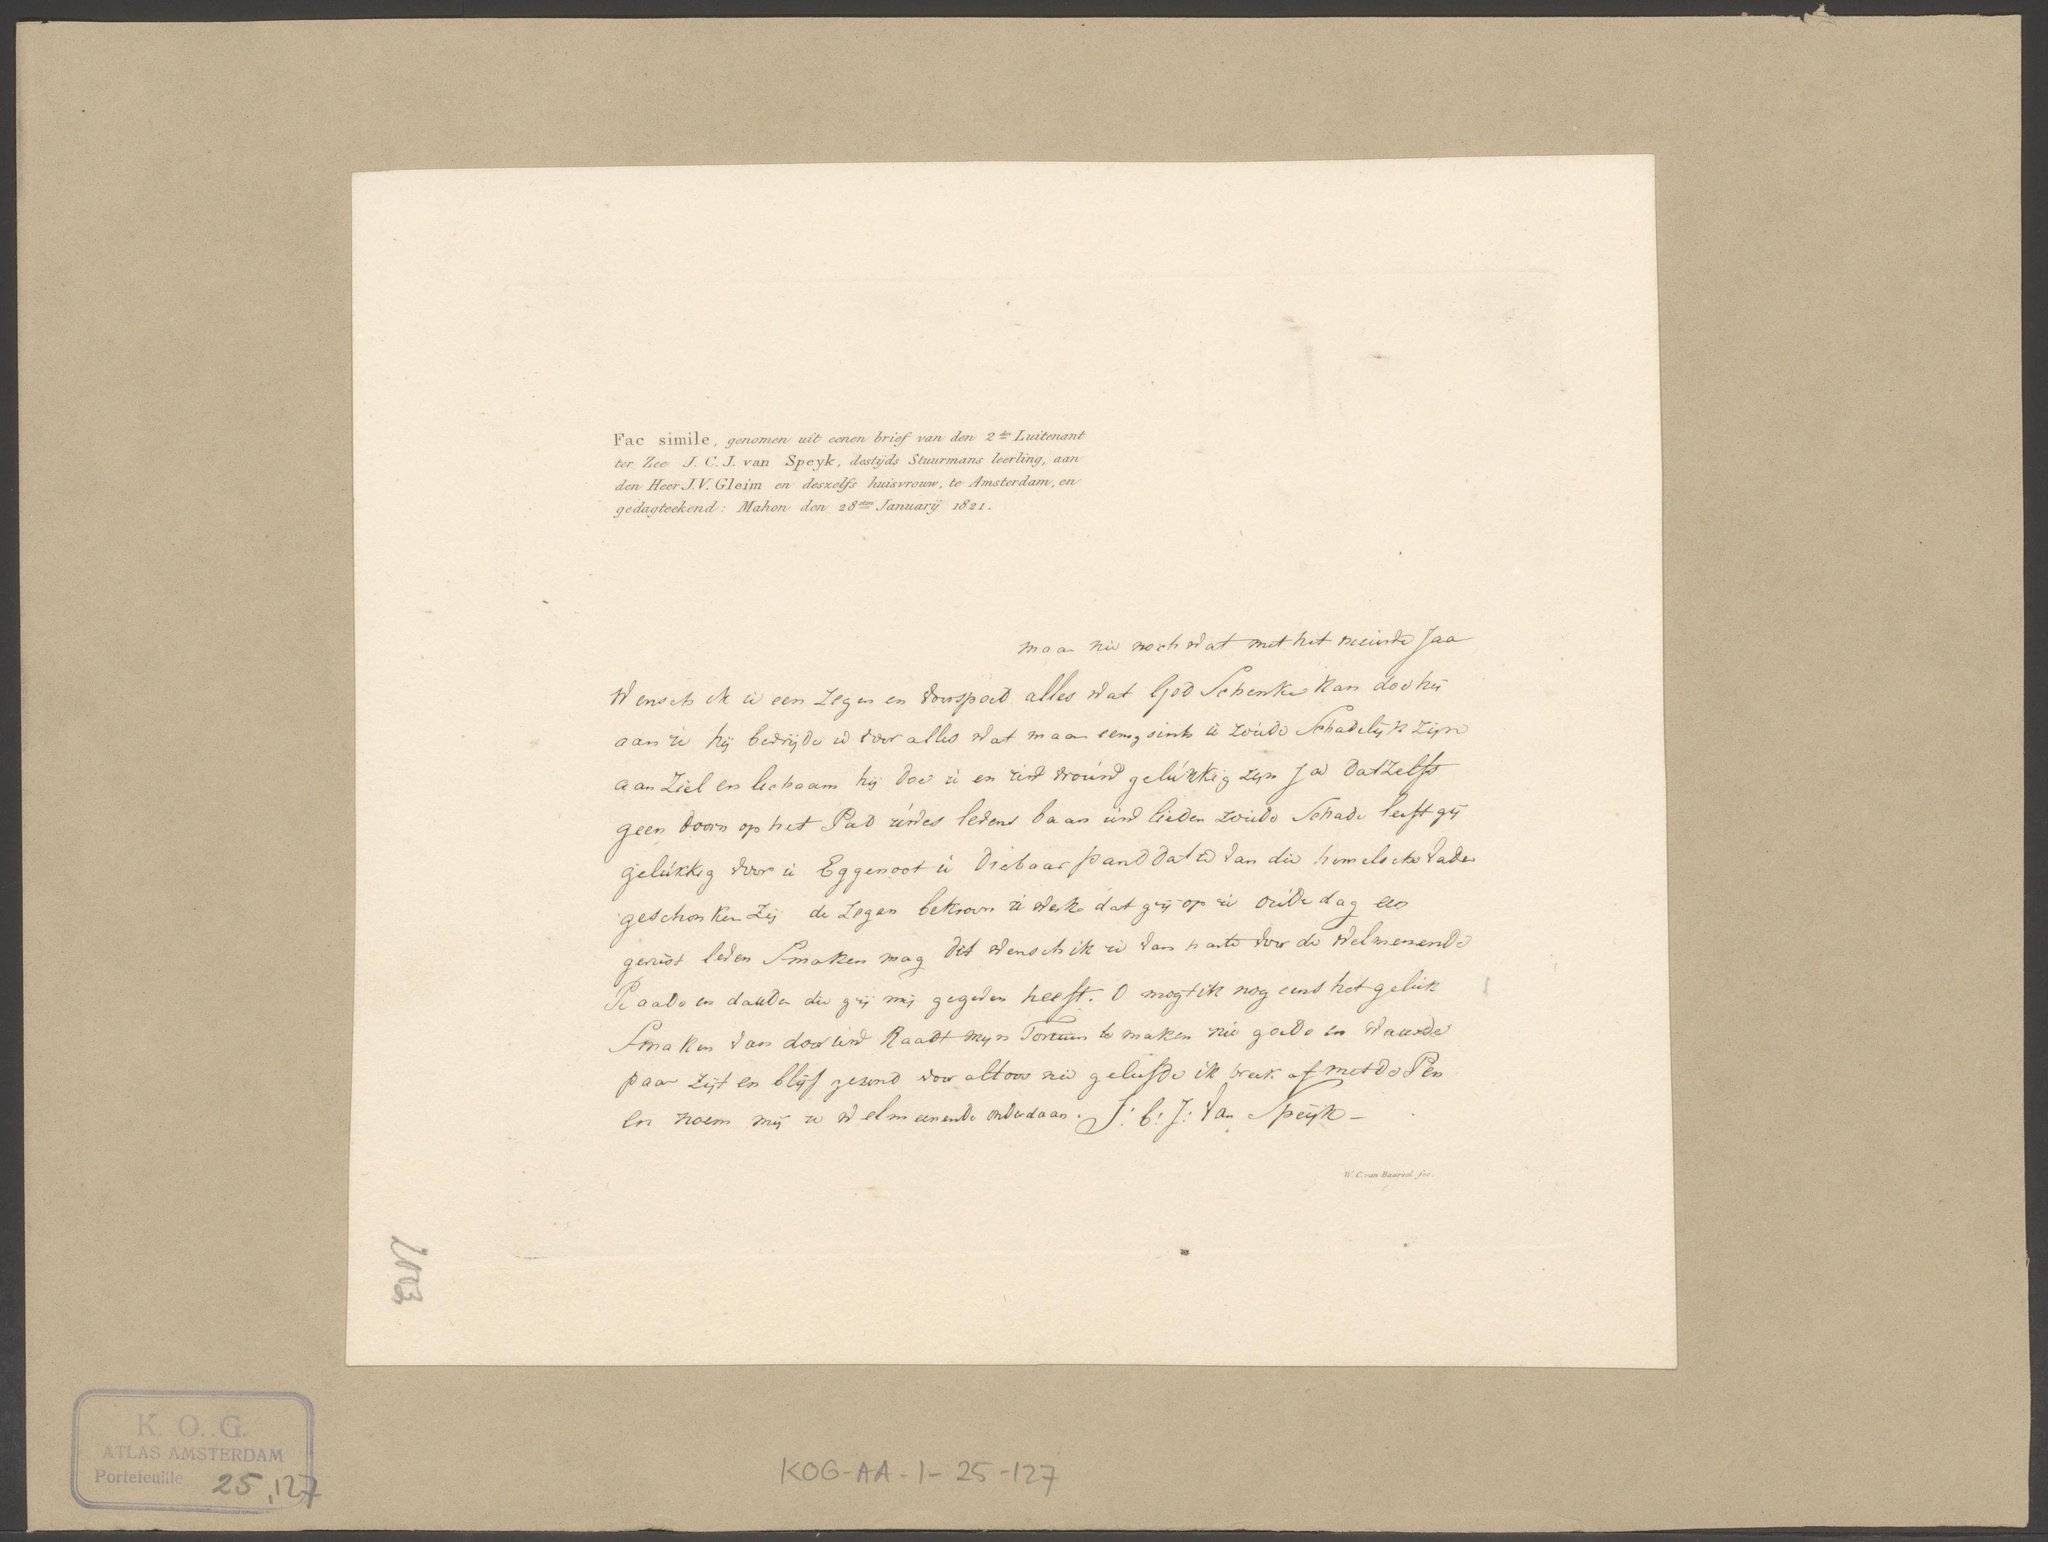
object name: print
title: Facsimile van een brief van Jan van Speyk aan de heer J.V. Gleim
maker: willem cornelis van baarsel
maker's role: print maker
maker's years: 1791-1854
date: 1831-1832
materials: paper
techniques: engraving, etching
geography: netherlands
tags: antwerp, jan van speyk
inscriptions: collector's mark: ‘25.127’ Lugt 1641b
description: Onderwerpsrubriek binnen de Atlas Amsterdam: Krijgswezen I: De Admiraliteit van Amsterdam, D. J.C. van Speyk.